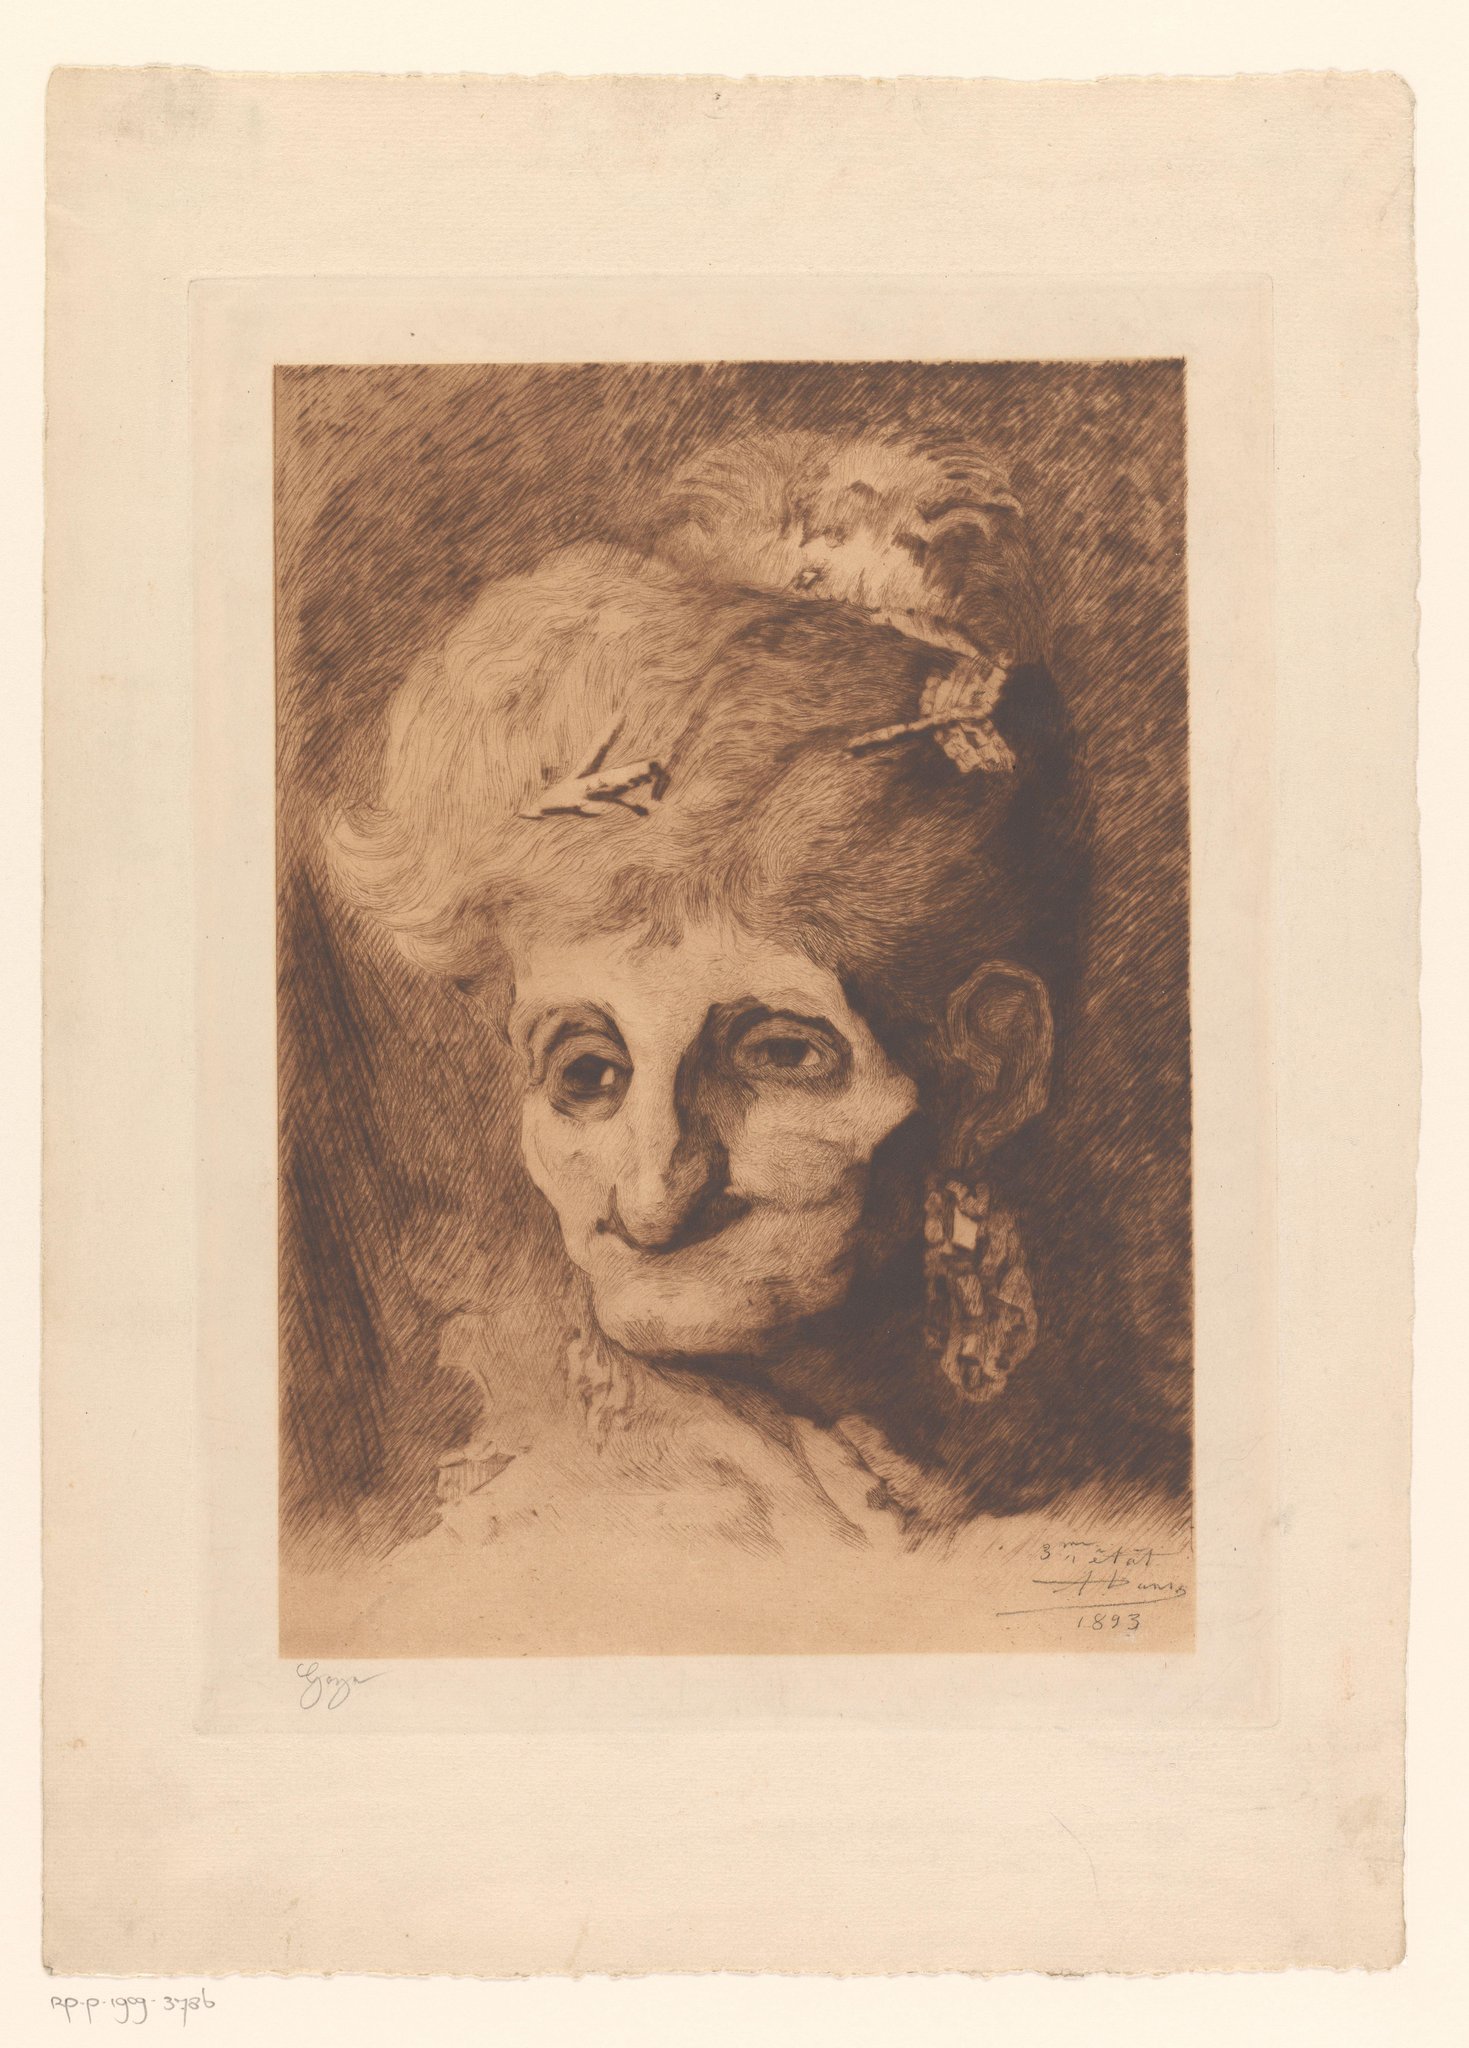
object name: print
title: Silenus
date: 1882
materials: paper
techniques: etching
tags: (story of) silenus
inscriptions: collector's mark: Lugt 2228, annotation: ‘2me etat’